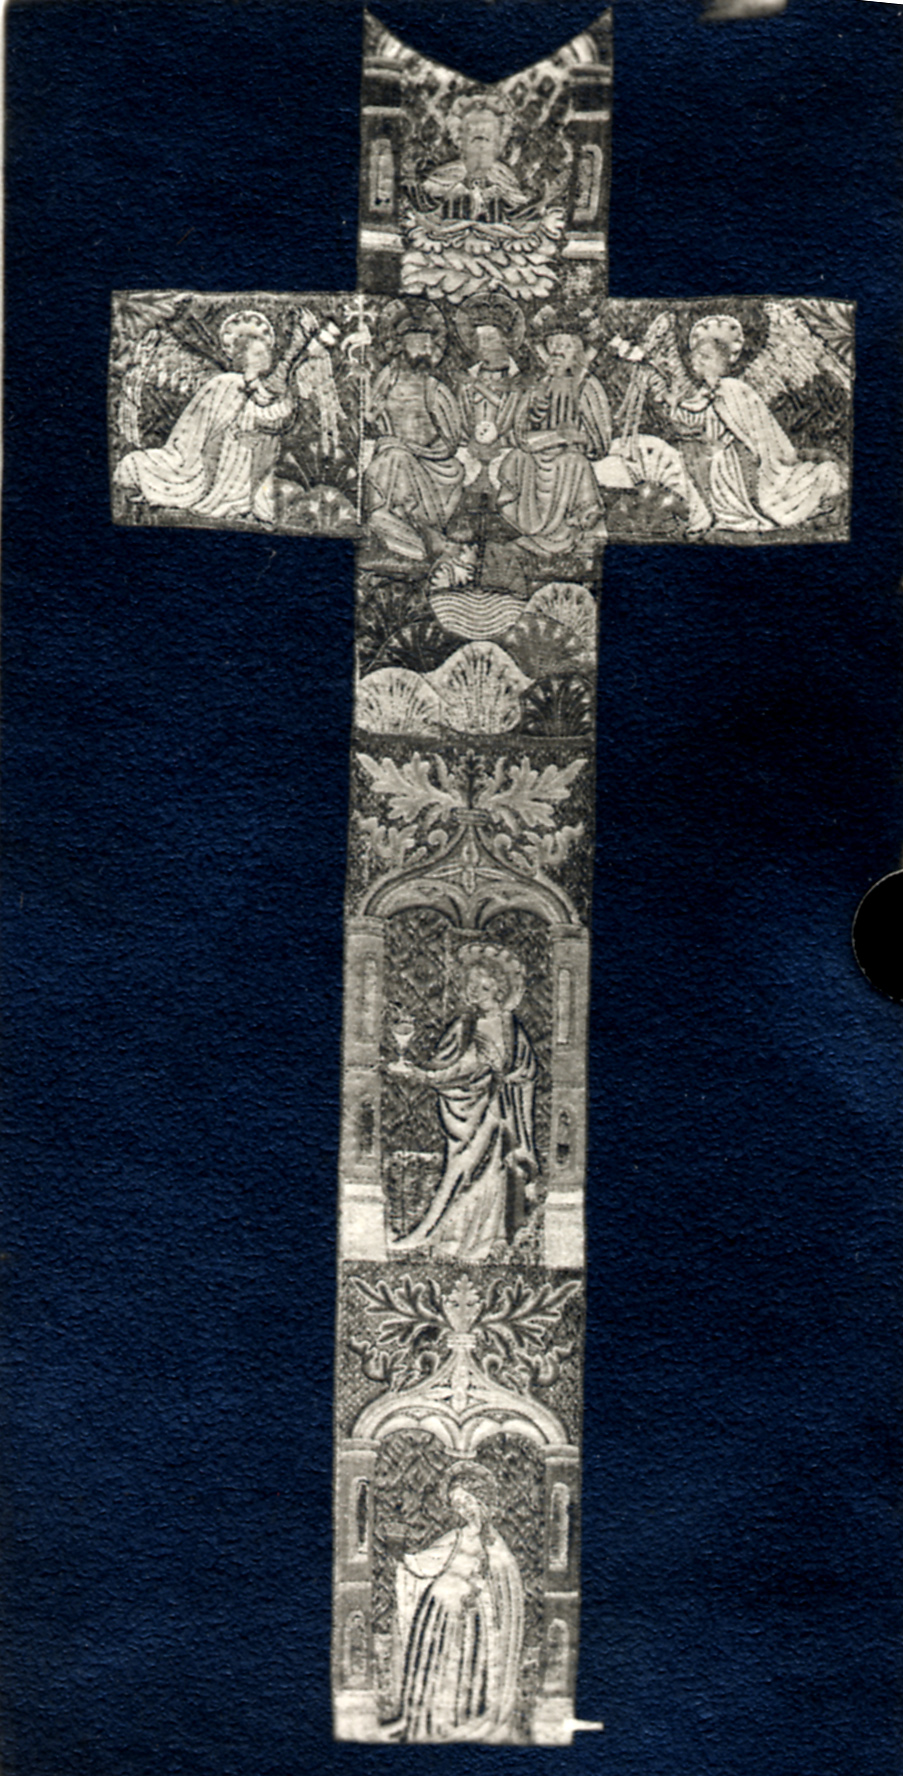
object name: orphrey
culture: british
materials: gold, silk, thread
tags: human figures,cross